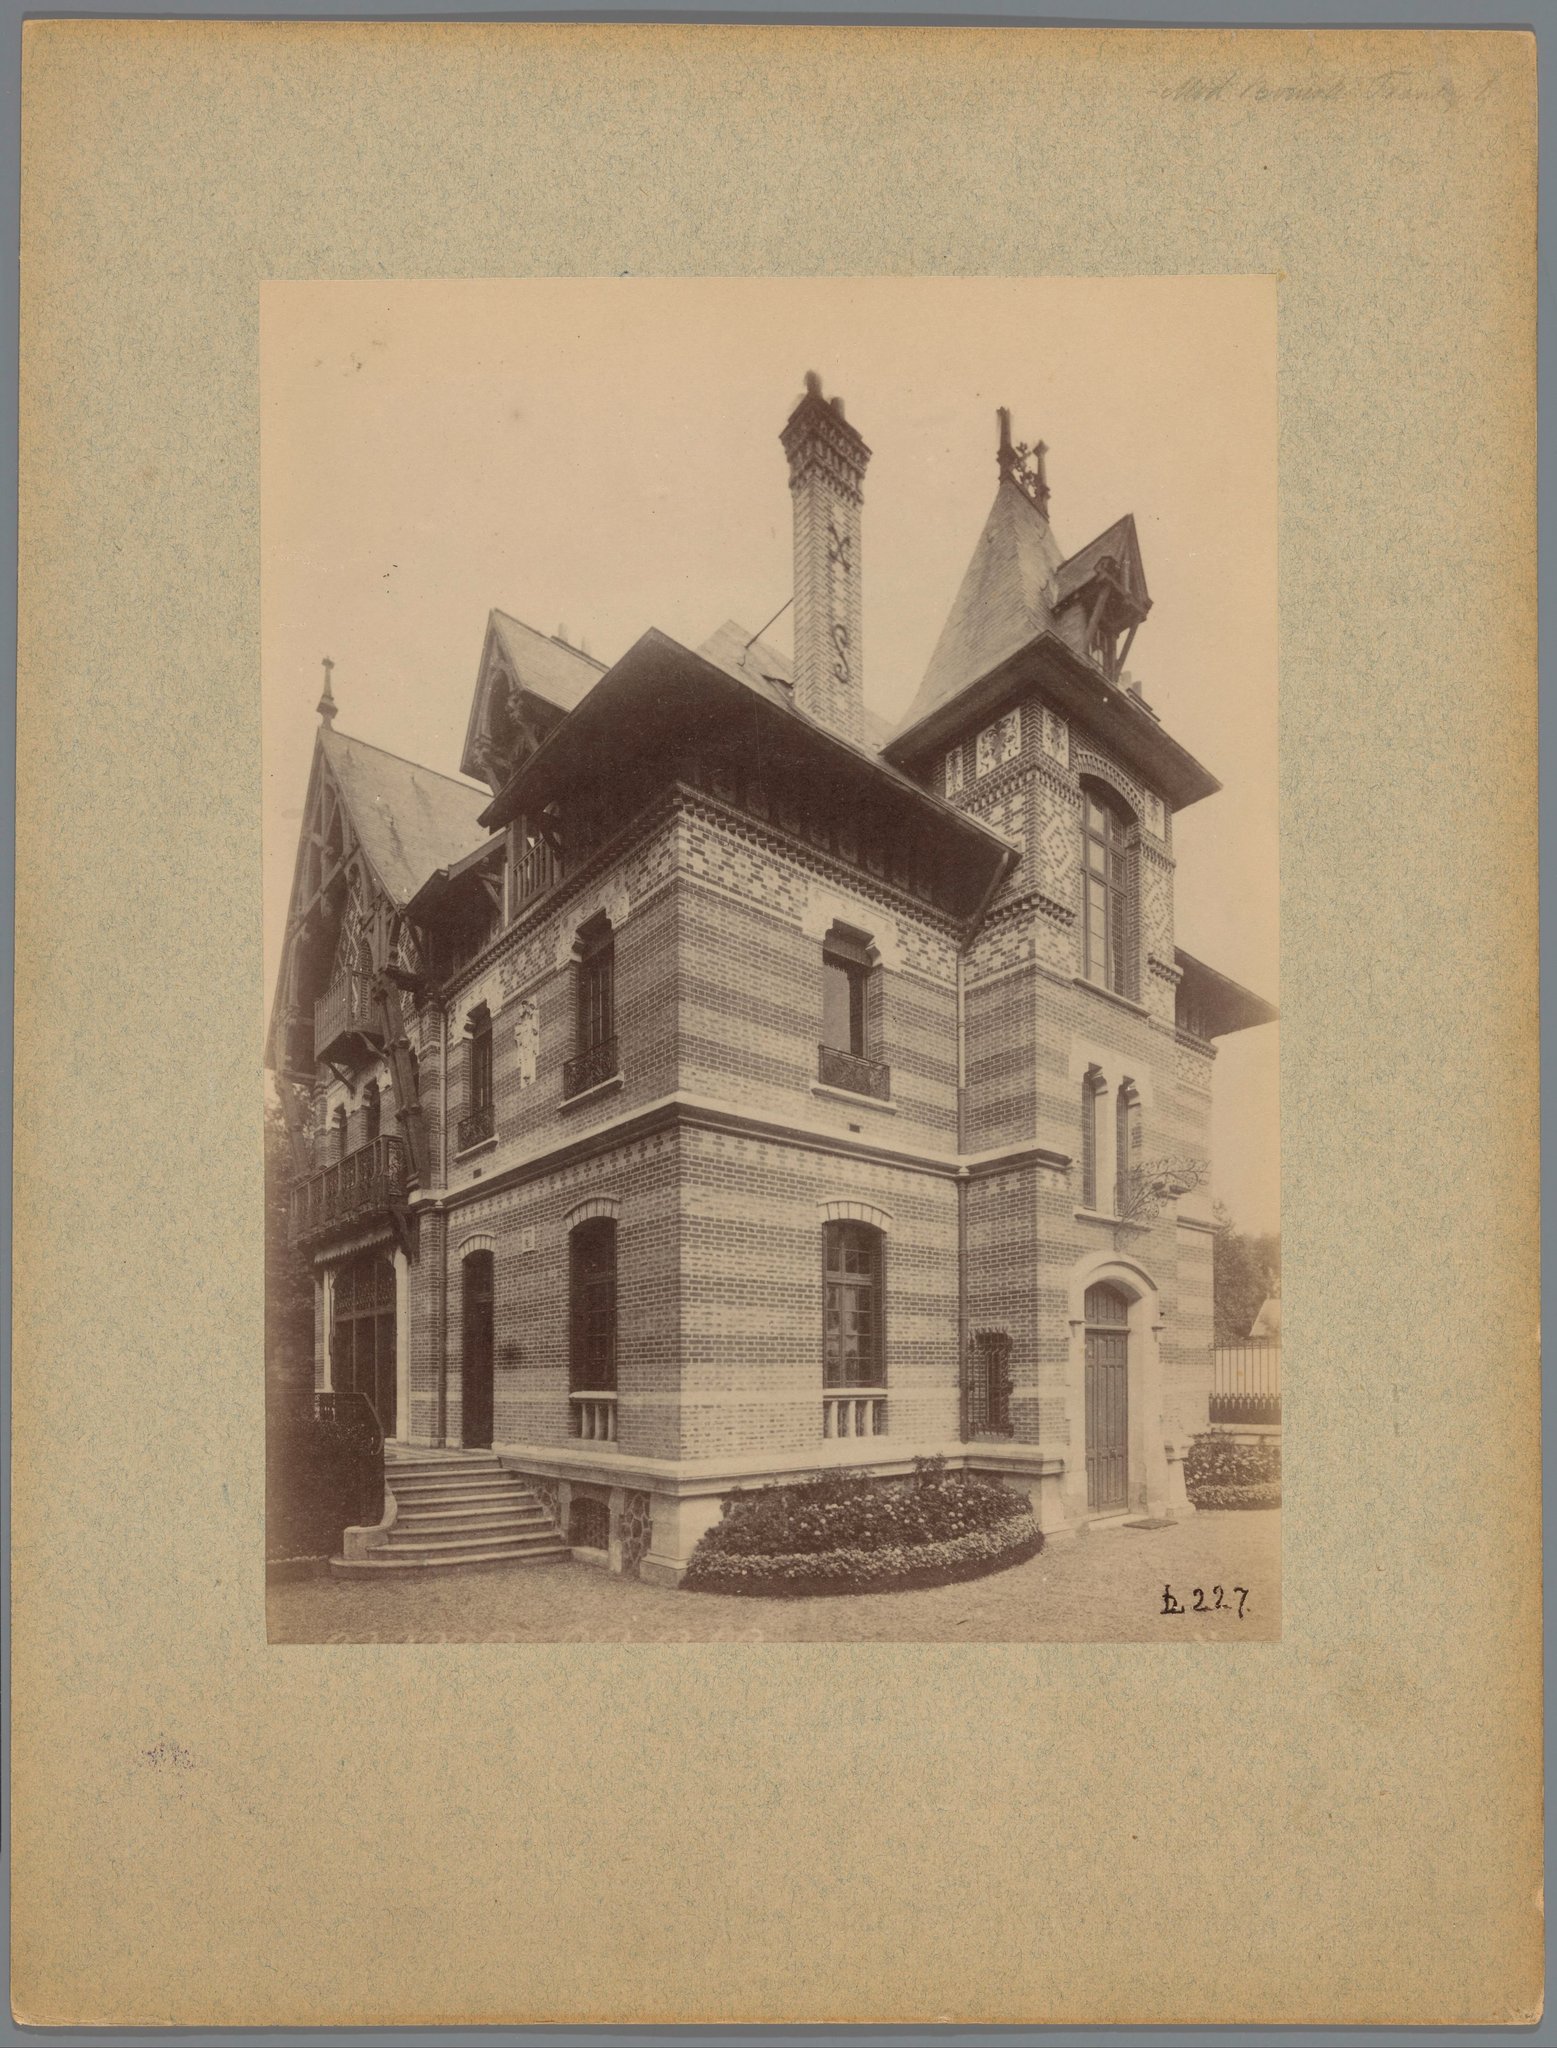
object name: photograph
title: Façade van een gebouw in Frankrijk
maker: Anonymous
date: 1875-1900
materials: cardboard, photographic support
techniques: albumen print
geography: france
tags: villa, balcony, façade (of house or building), france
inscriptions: number: ‘[...]227.’, name: ‘KUNSTBOEKHANDEL J. A. G. DE LEUR PHOTOGRAAf - UITGEVER Huigenspark, 40b. DEN HAAG’, collector's mark: Lugt 3937, inscription: ‘Mod. Bouwk Frankrijk’